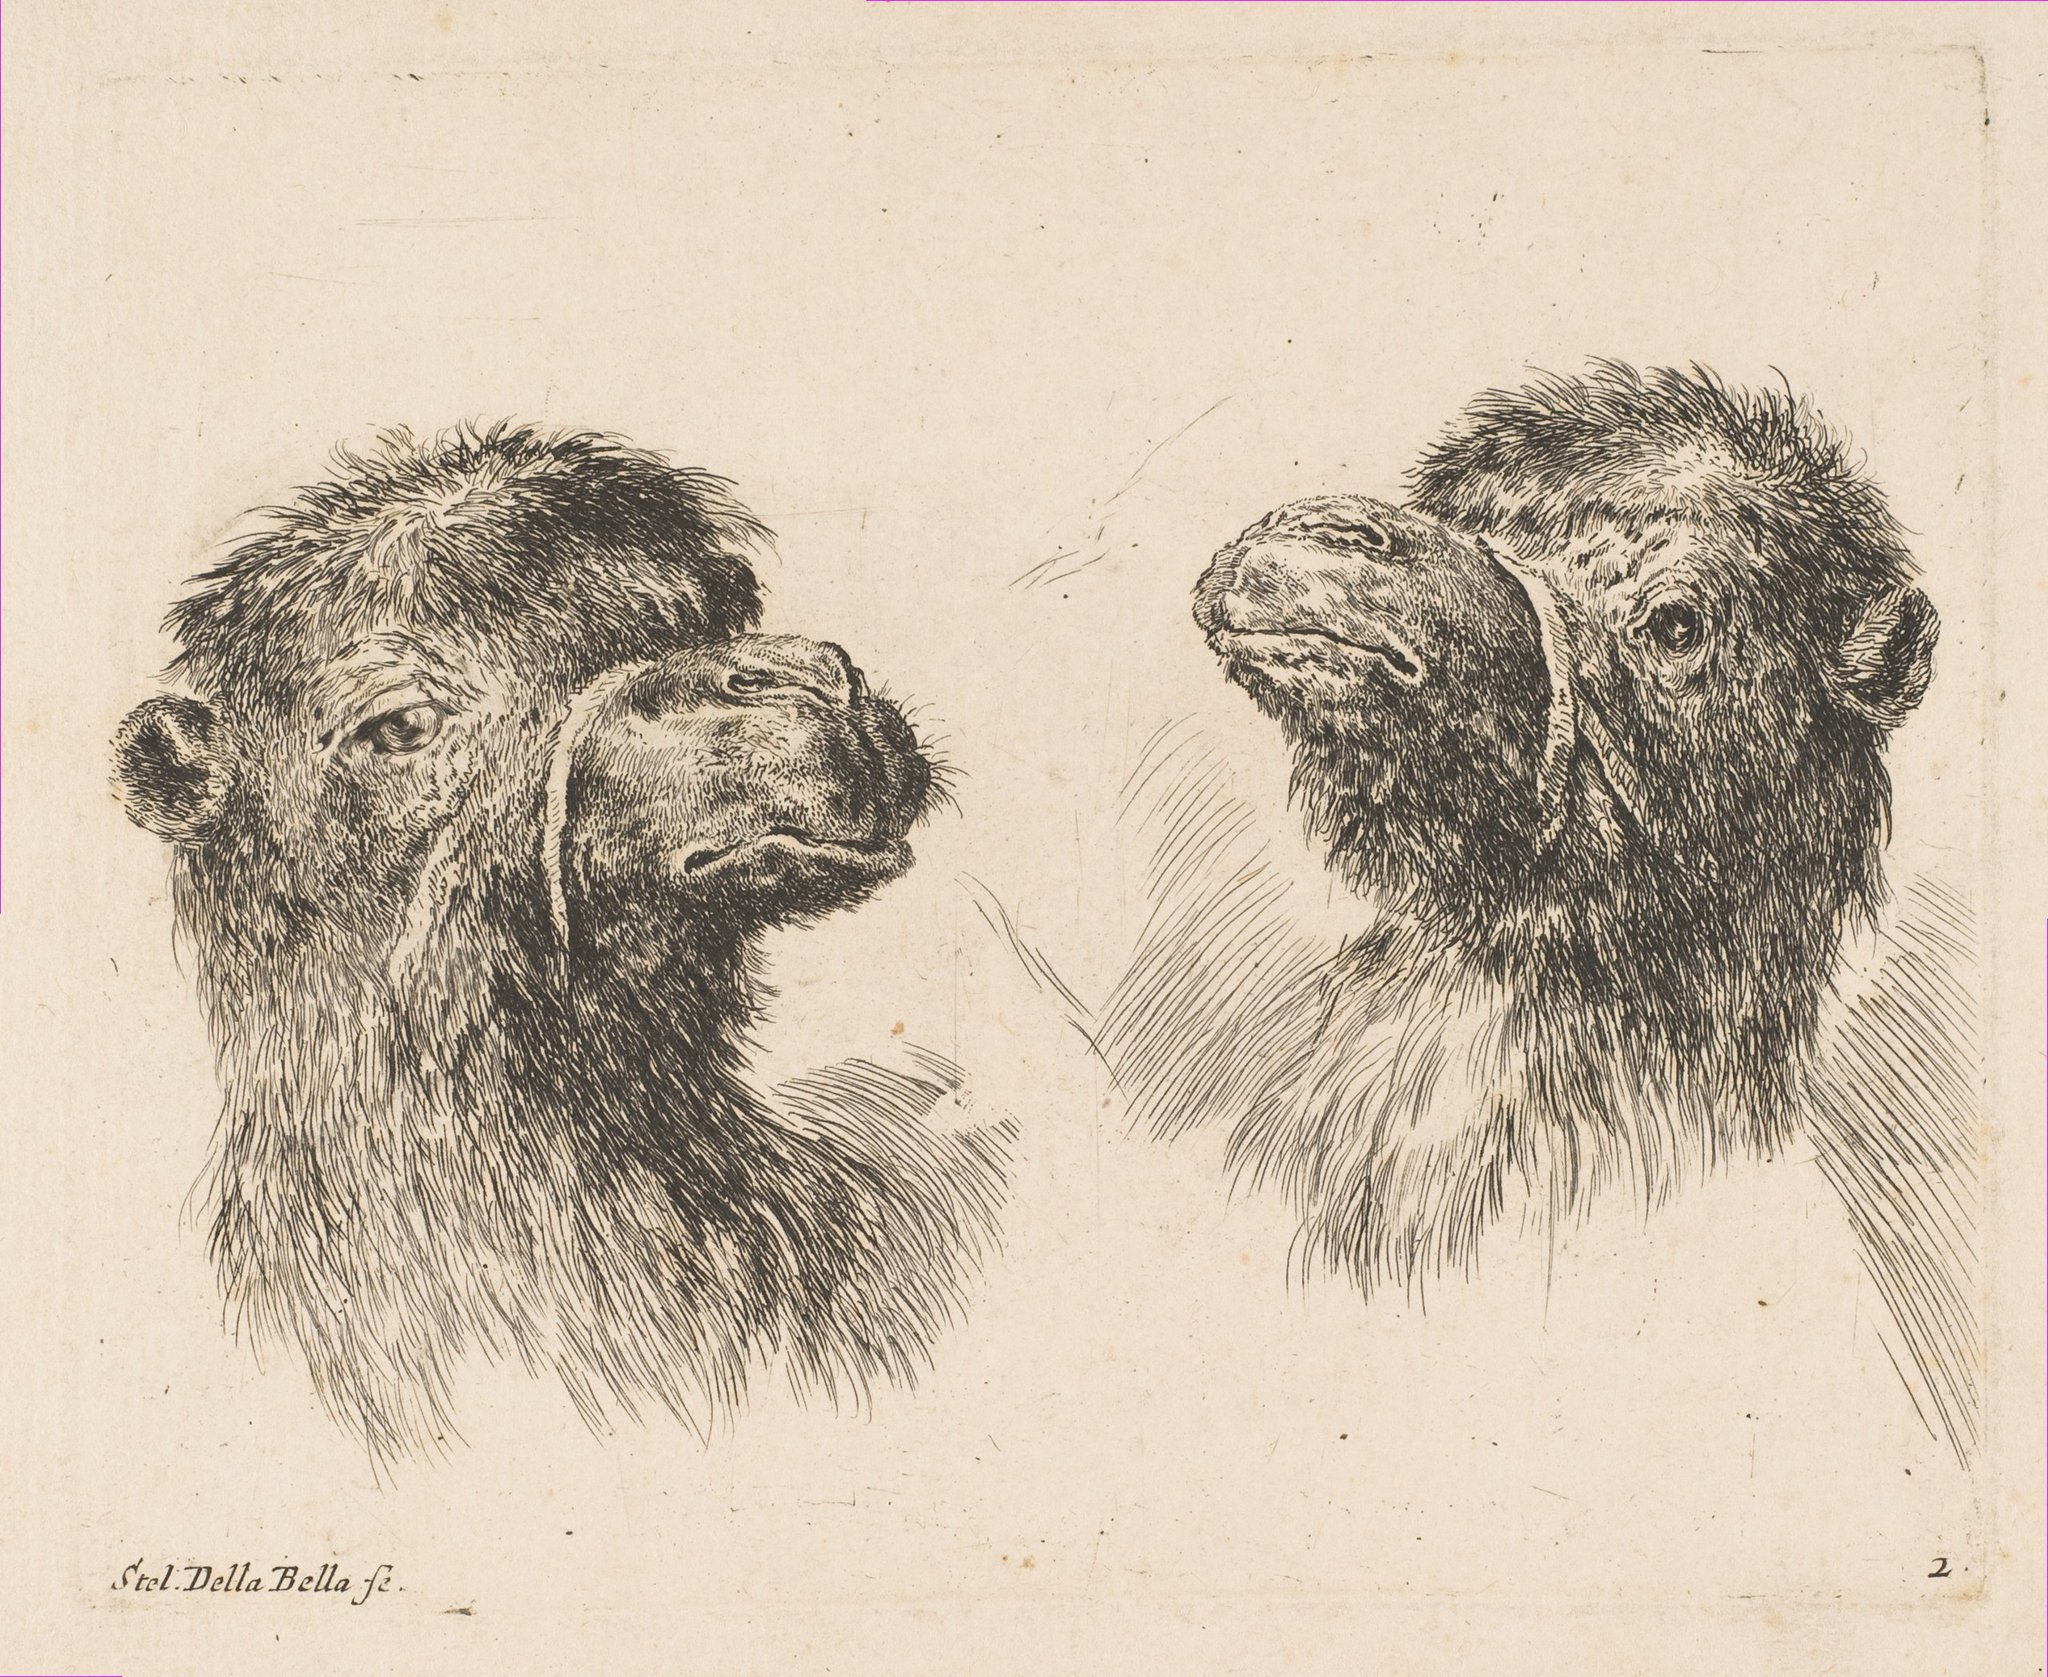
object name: print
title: Two Camel Heads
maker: stefano della bella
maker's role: artist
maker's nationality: italian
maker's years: 1610-1664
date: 1641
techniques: etching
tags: camels